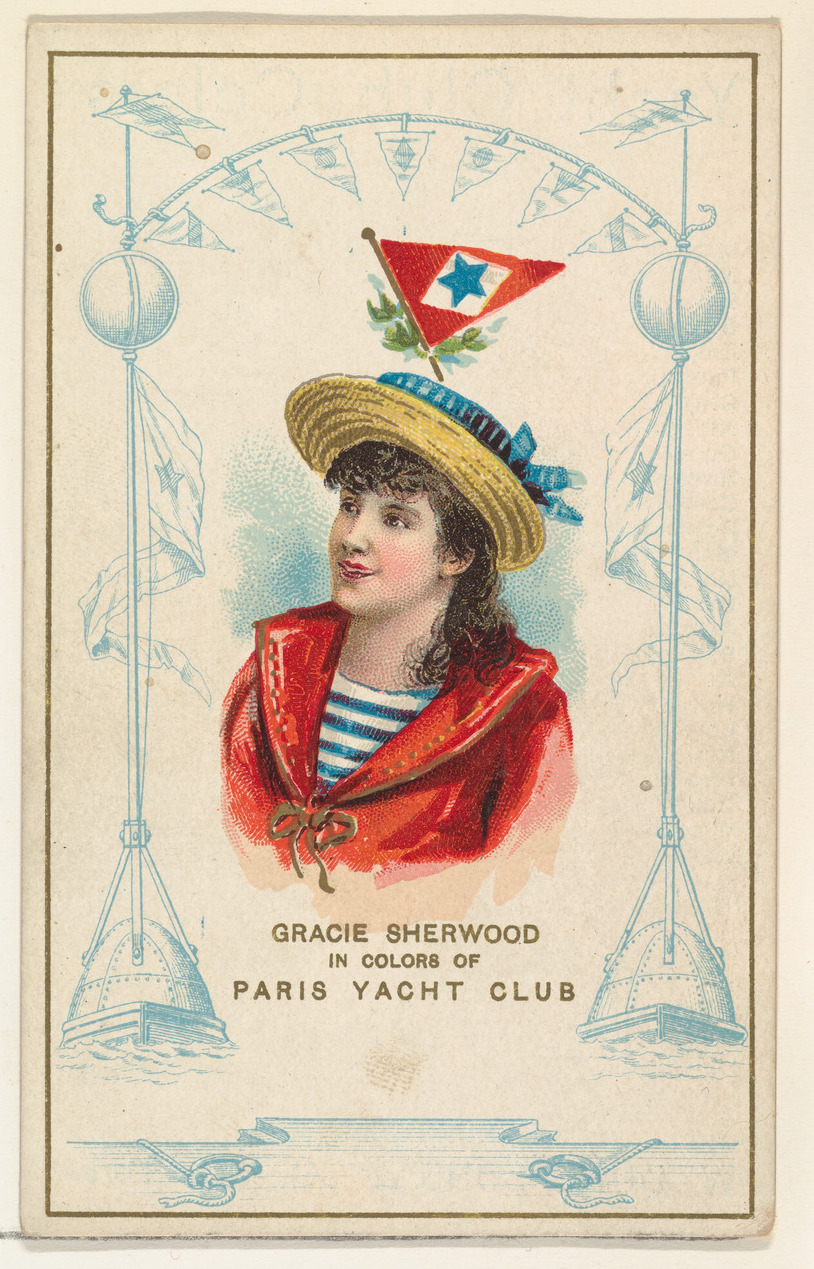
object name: print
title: Gracie Sherwood in Colors of the Paris Yacht Club, from the Yacht Colors of the World series (N140) issued by Duke Sons & Co. to promote Honest Long Cut Tobacco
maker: w. duke, sons & co.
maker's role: publisher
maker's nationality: american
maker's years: 1870-1920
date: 1890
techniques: color lithograph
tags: portraits,women,flags